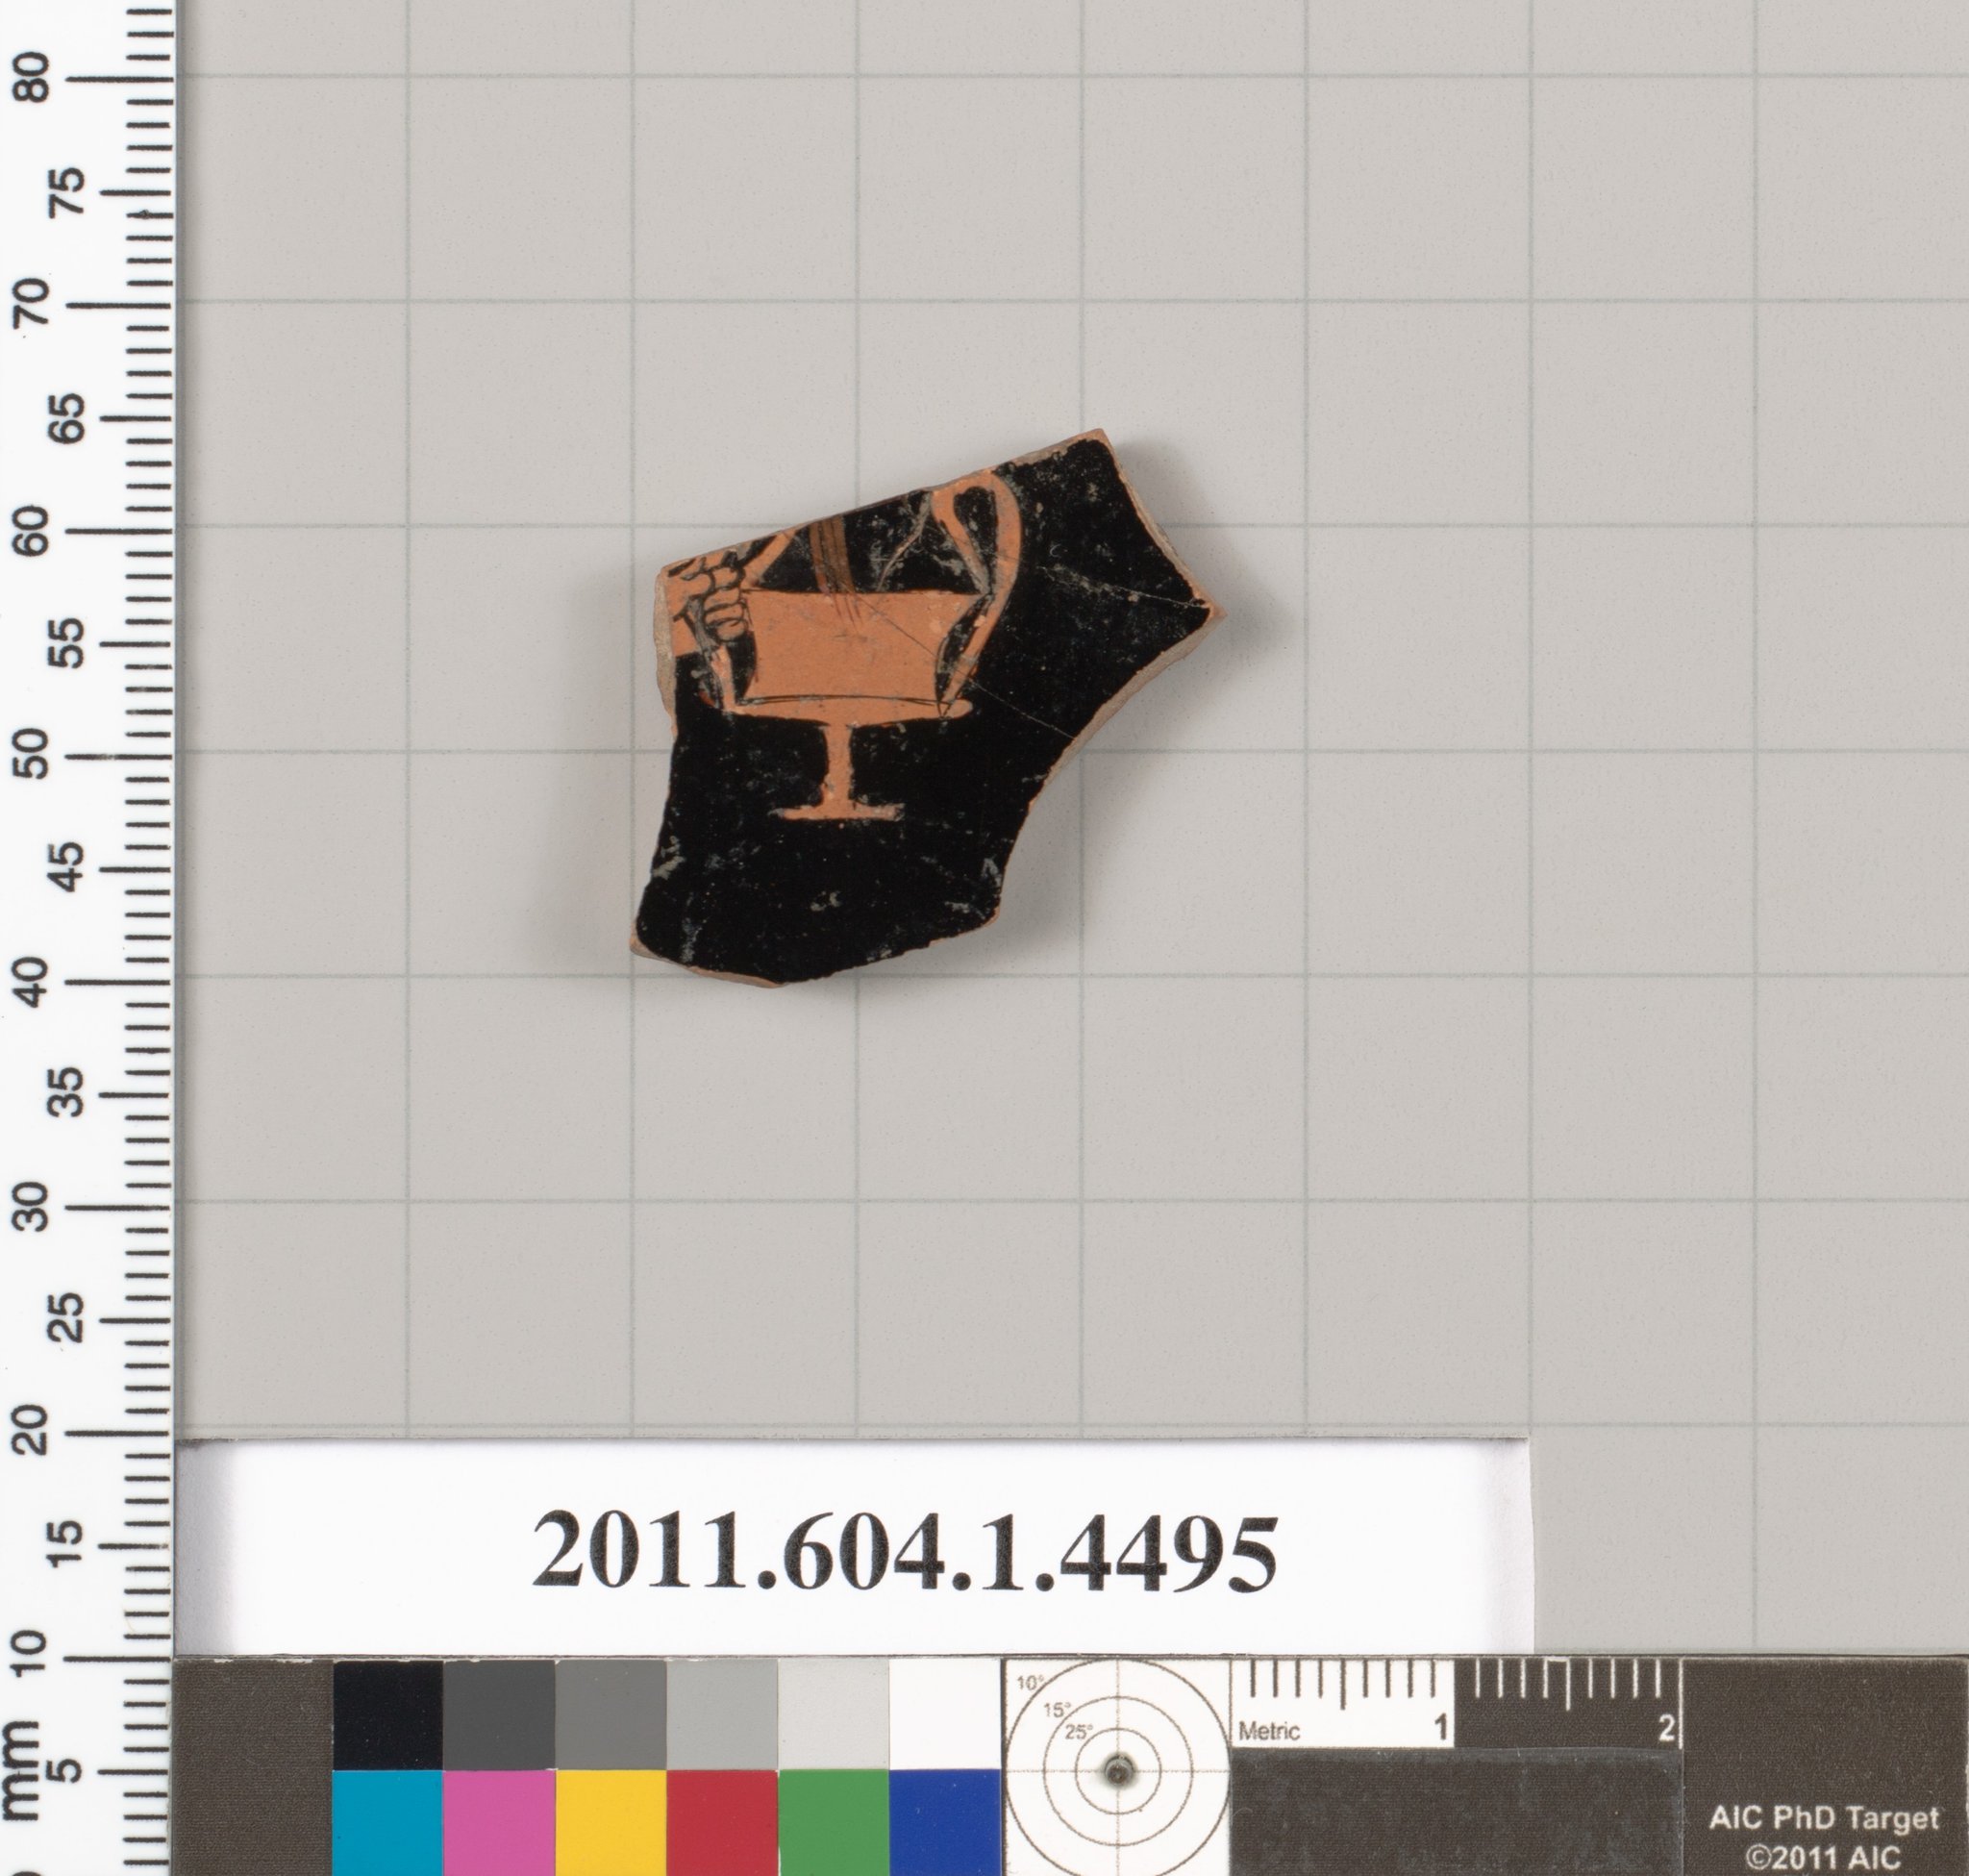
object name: kylix fragment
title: Terracotta fragment of a kylix (drinking cup)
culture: greek, attic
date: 500-480 BCE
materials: terracotta